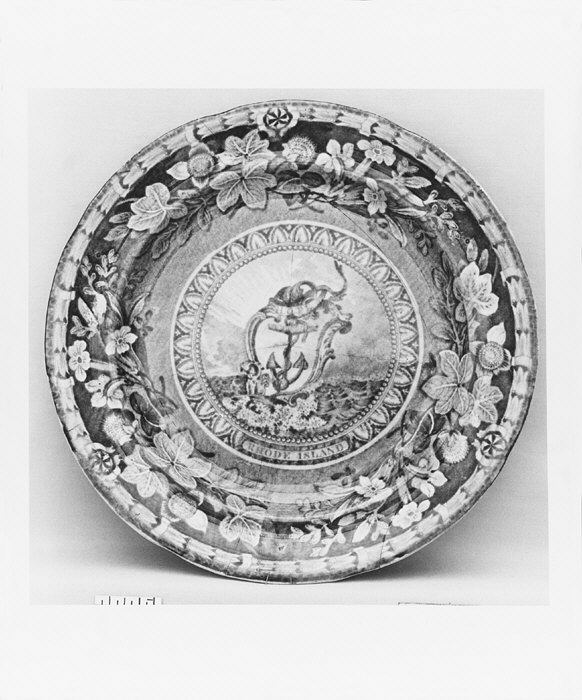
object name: plate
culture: british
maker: thomas mayer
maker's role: maker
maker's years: 1823-1838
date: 1826-1835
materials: earthenware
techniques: transfer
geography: england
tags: flowers